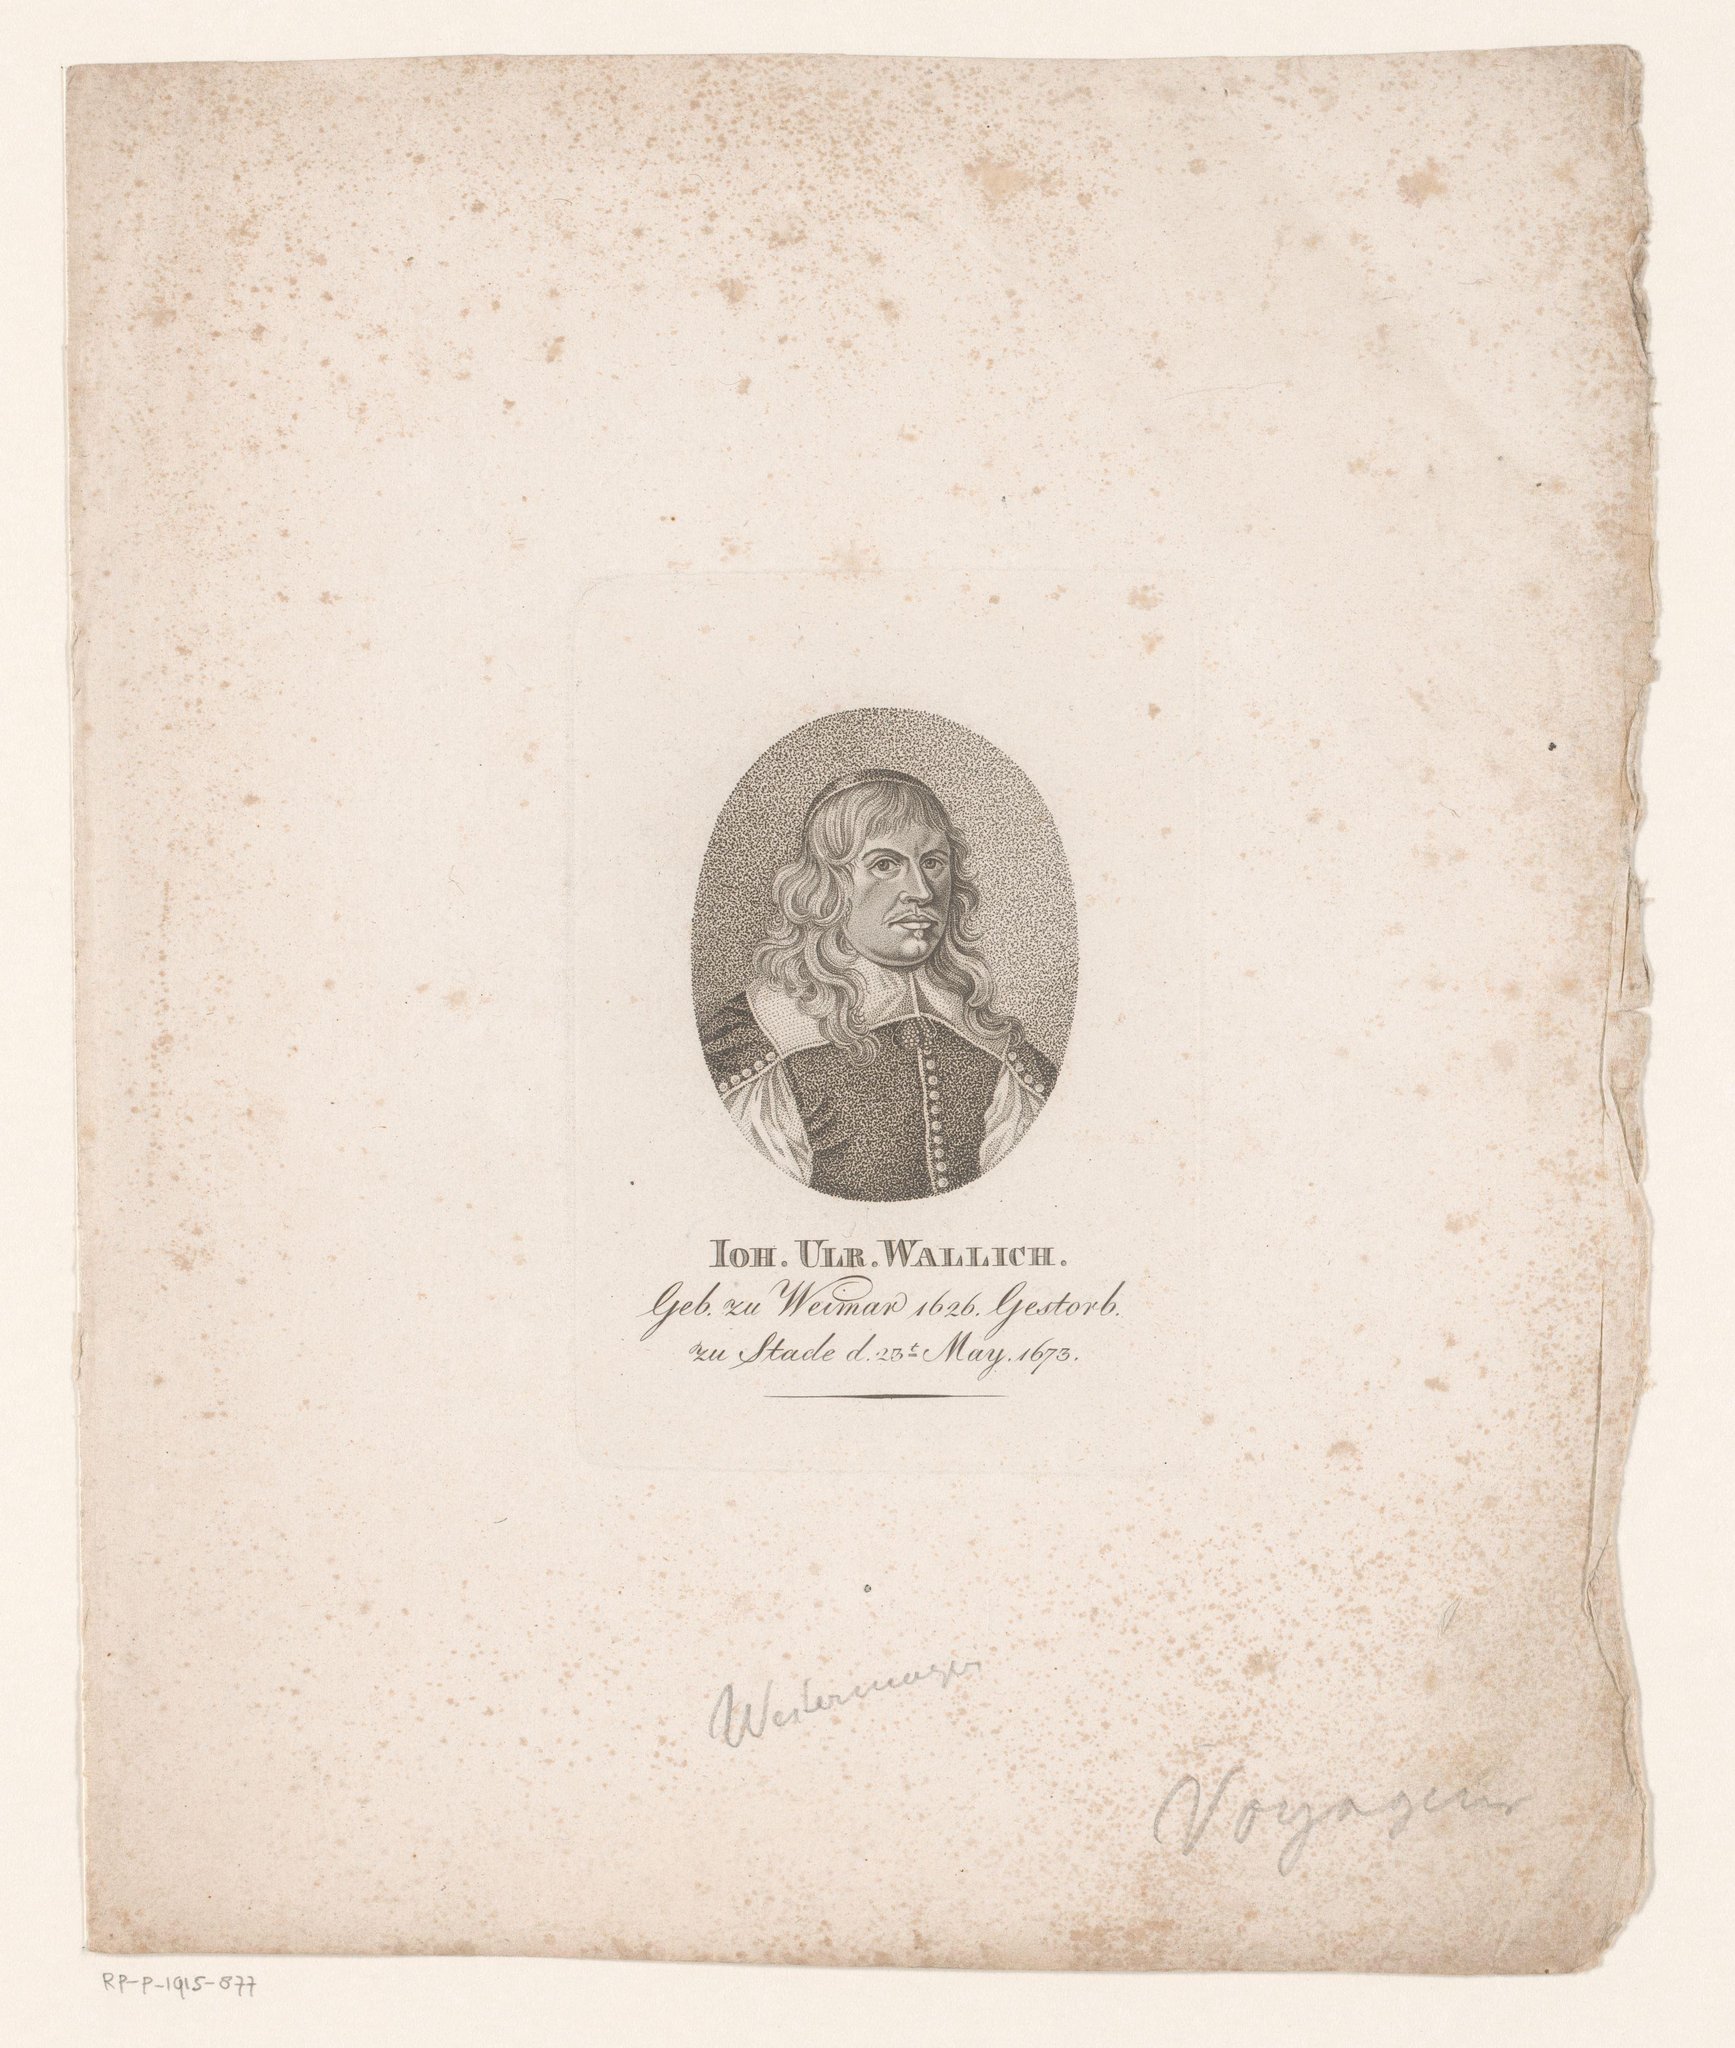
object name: print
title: Portret van Johann Ulrich Wallich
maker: konrad westermayr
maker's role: print maker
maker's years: 1765-1834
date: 1775-1834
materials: paper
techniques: engraving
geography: germany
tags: historical persons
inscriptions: collector's mark: Lugt 2228